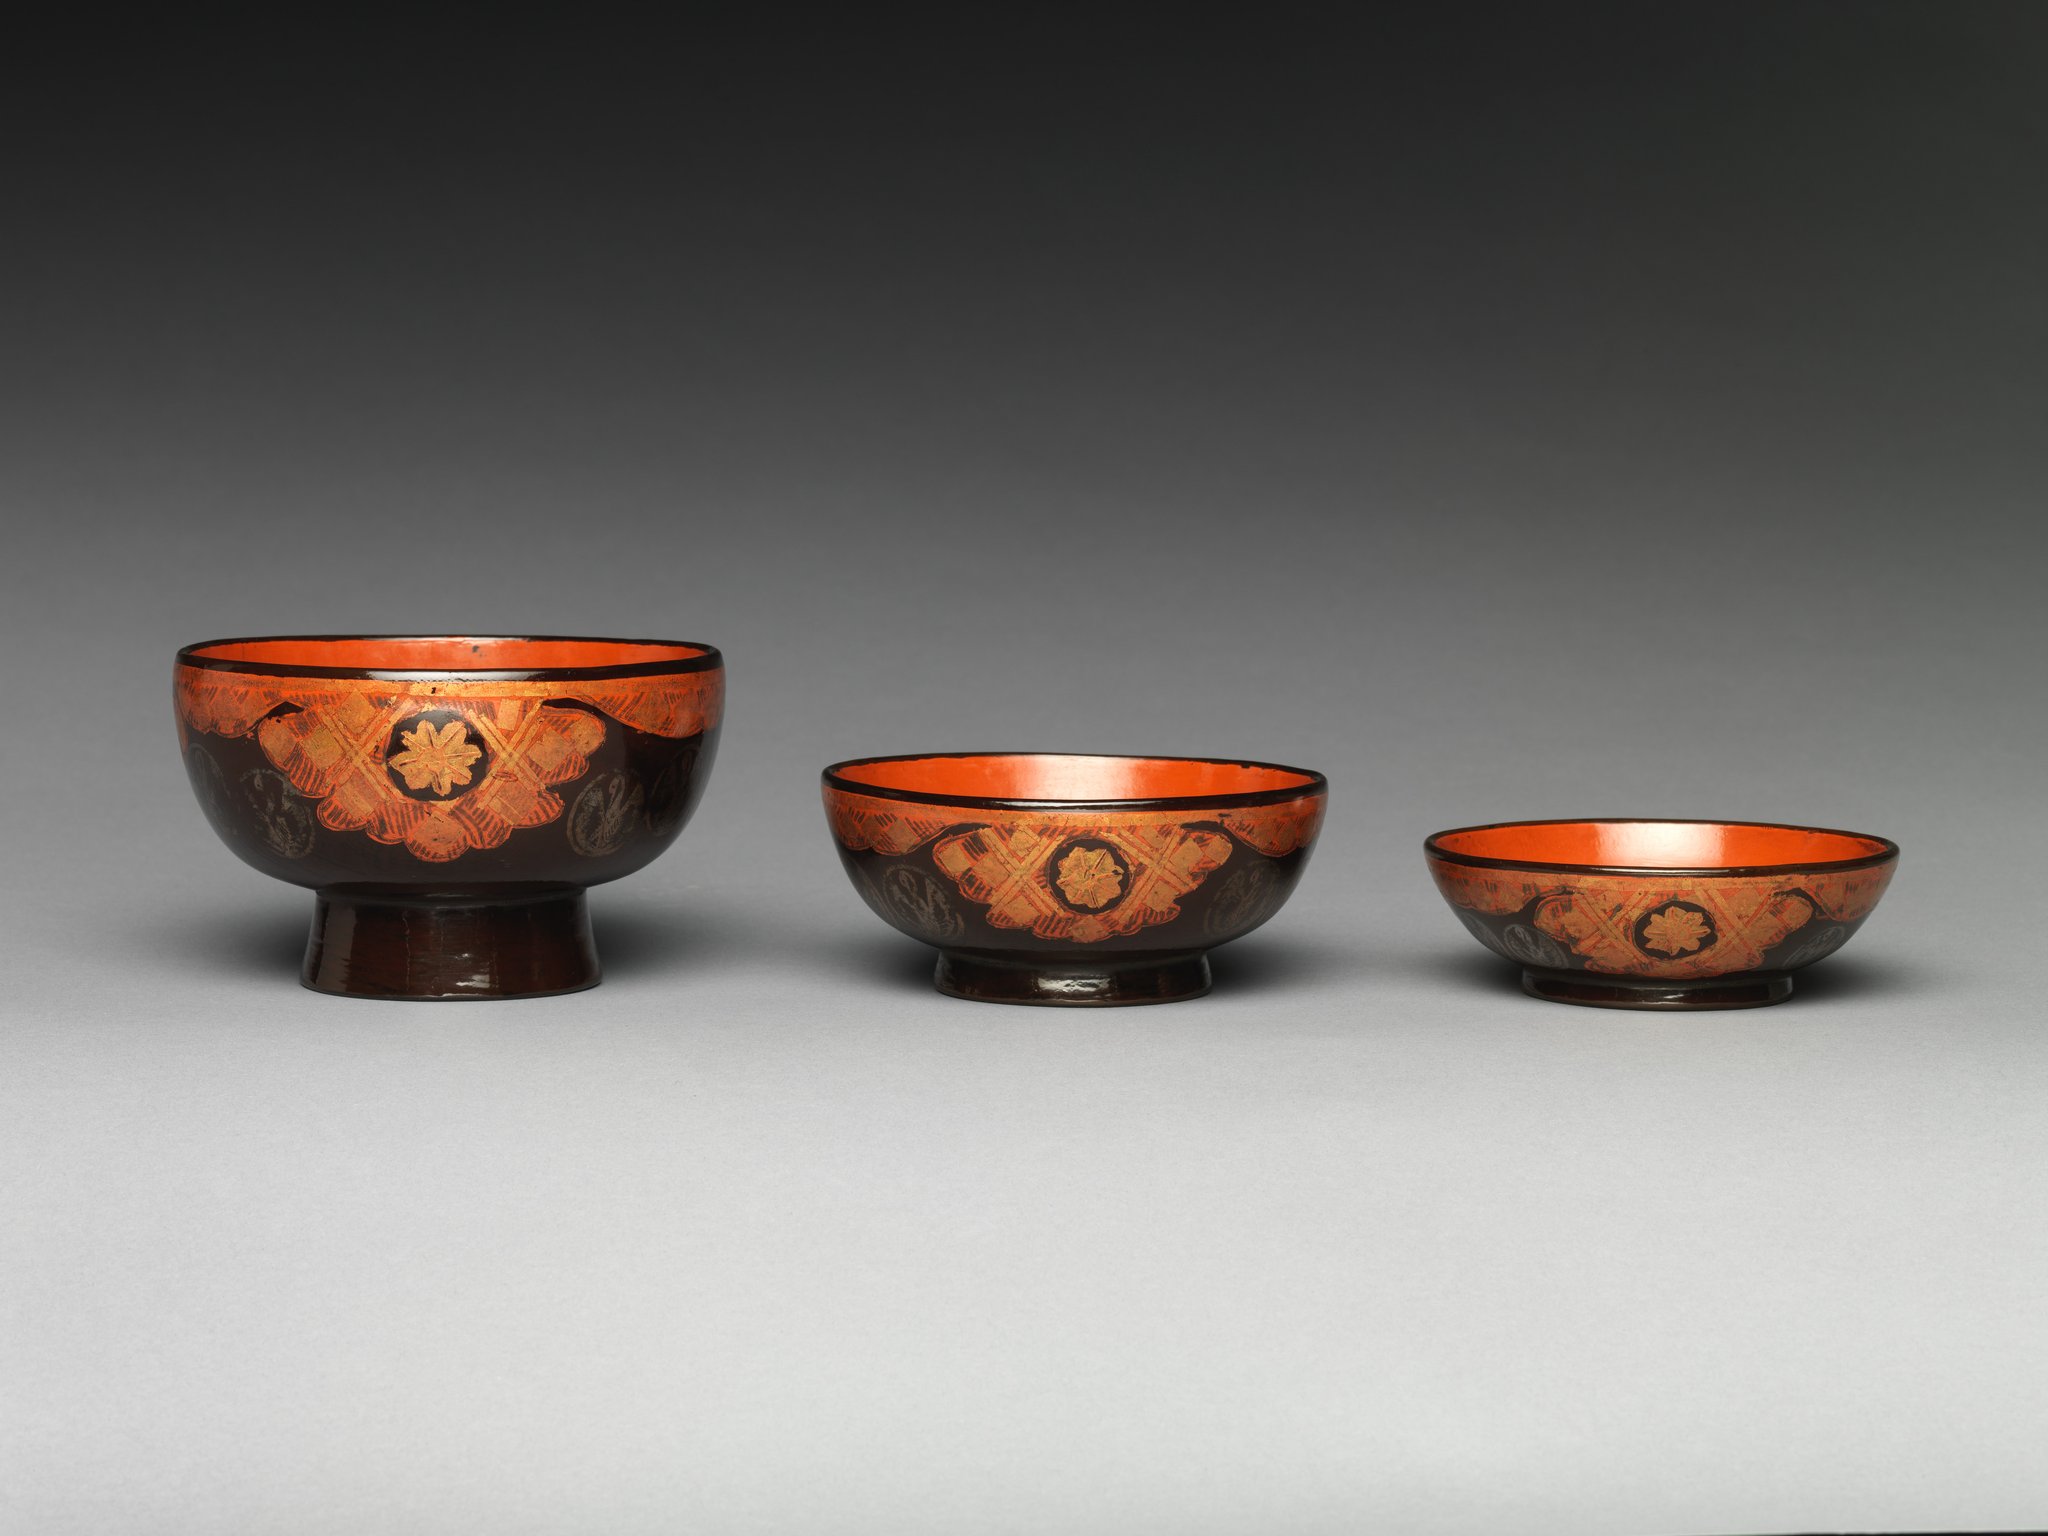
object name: bowl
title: Three Nesting Bowls (Mitsuwan)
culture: japanese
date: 1573-1615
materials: foil, gold, lacquer, silver, wood